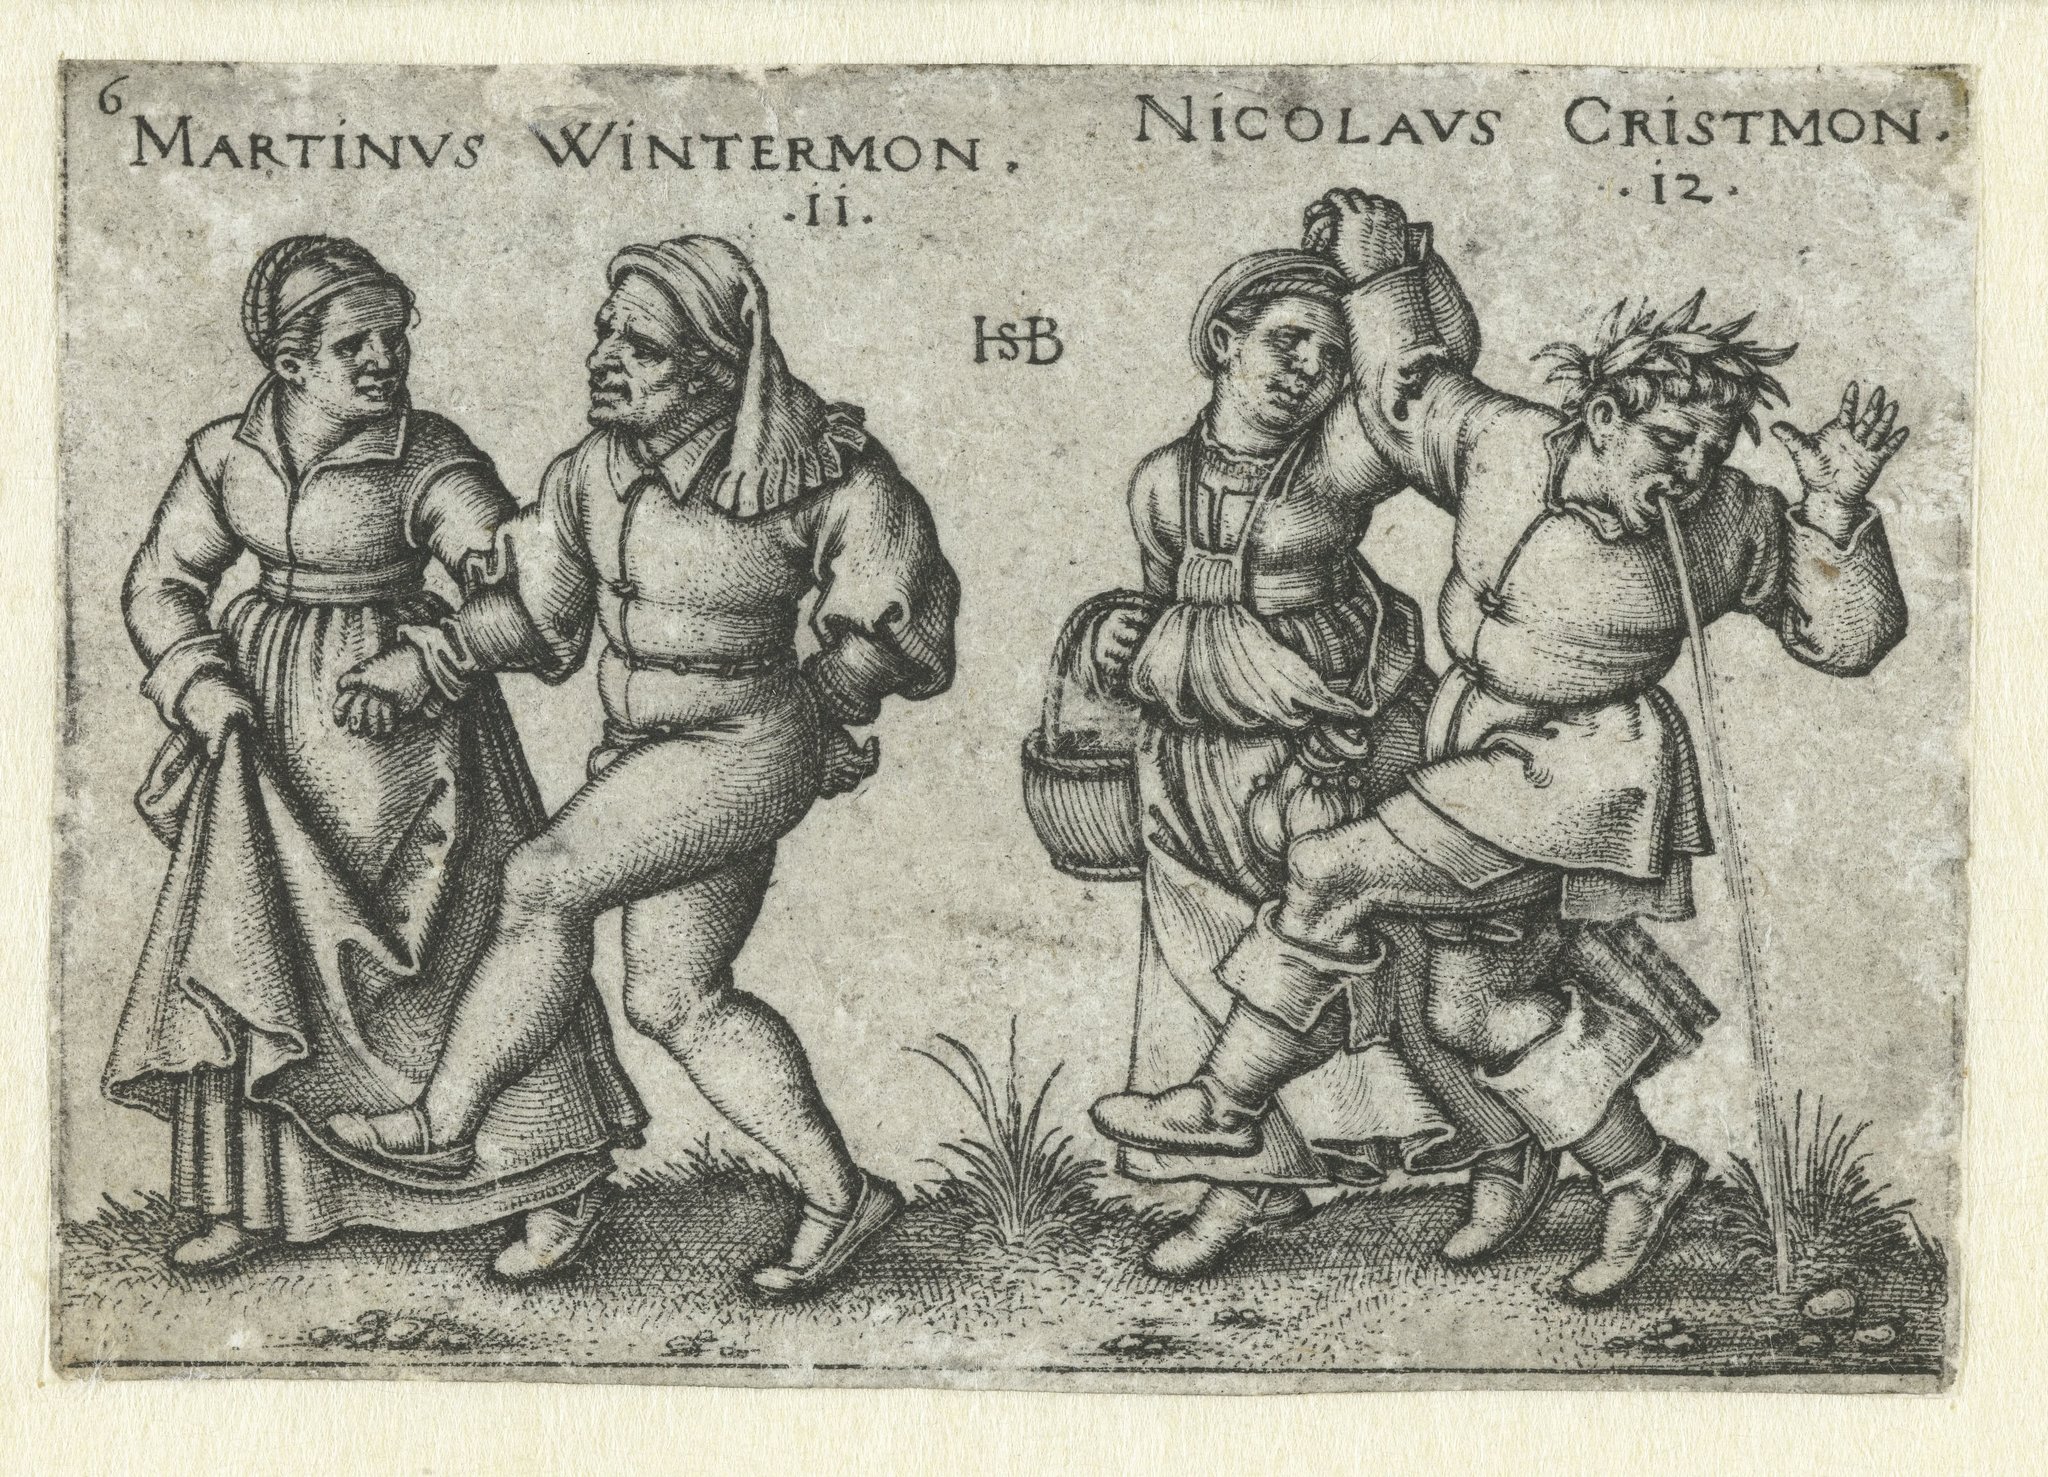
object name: print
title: Dansende boerenparen, man geeft over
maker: hans sebald beham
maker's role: designer, draughtsman, print maker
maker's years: 1500-1550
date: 1546-1547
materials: paper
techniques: engraving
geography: frankfurt am main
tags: vomiting, one pair dancing; man and woman dancing as a couple, farmers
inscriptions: collector's mark: Lugt 2228a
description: De twaalf dansende boerenparen van deze serie prenten vertegenwoordigen de twaalf maanden. Volgens de opschriften Martinvs Wintermon[at] en Nicolavs Cristmon[at] gaat het hier om de maanden November en December